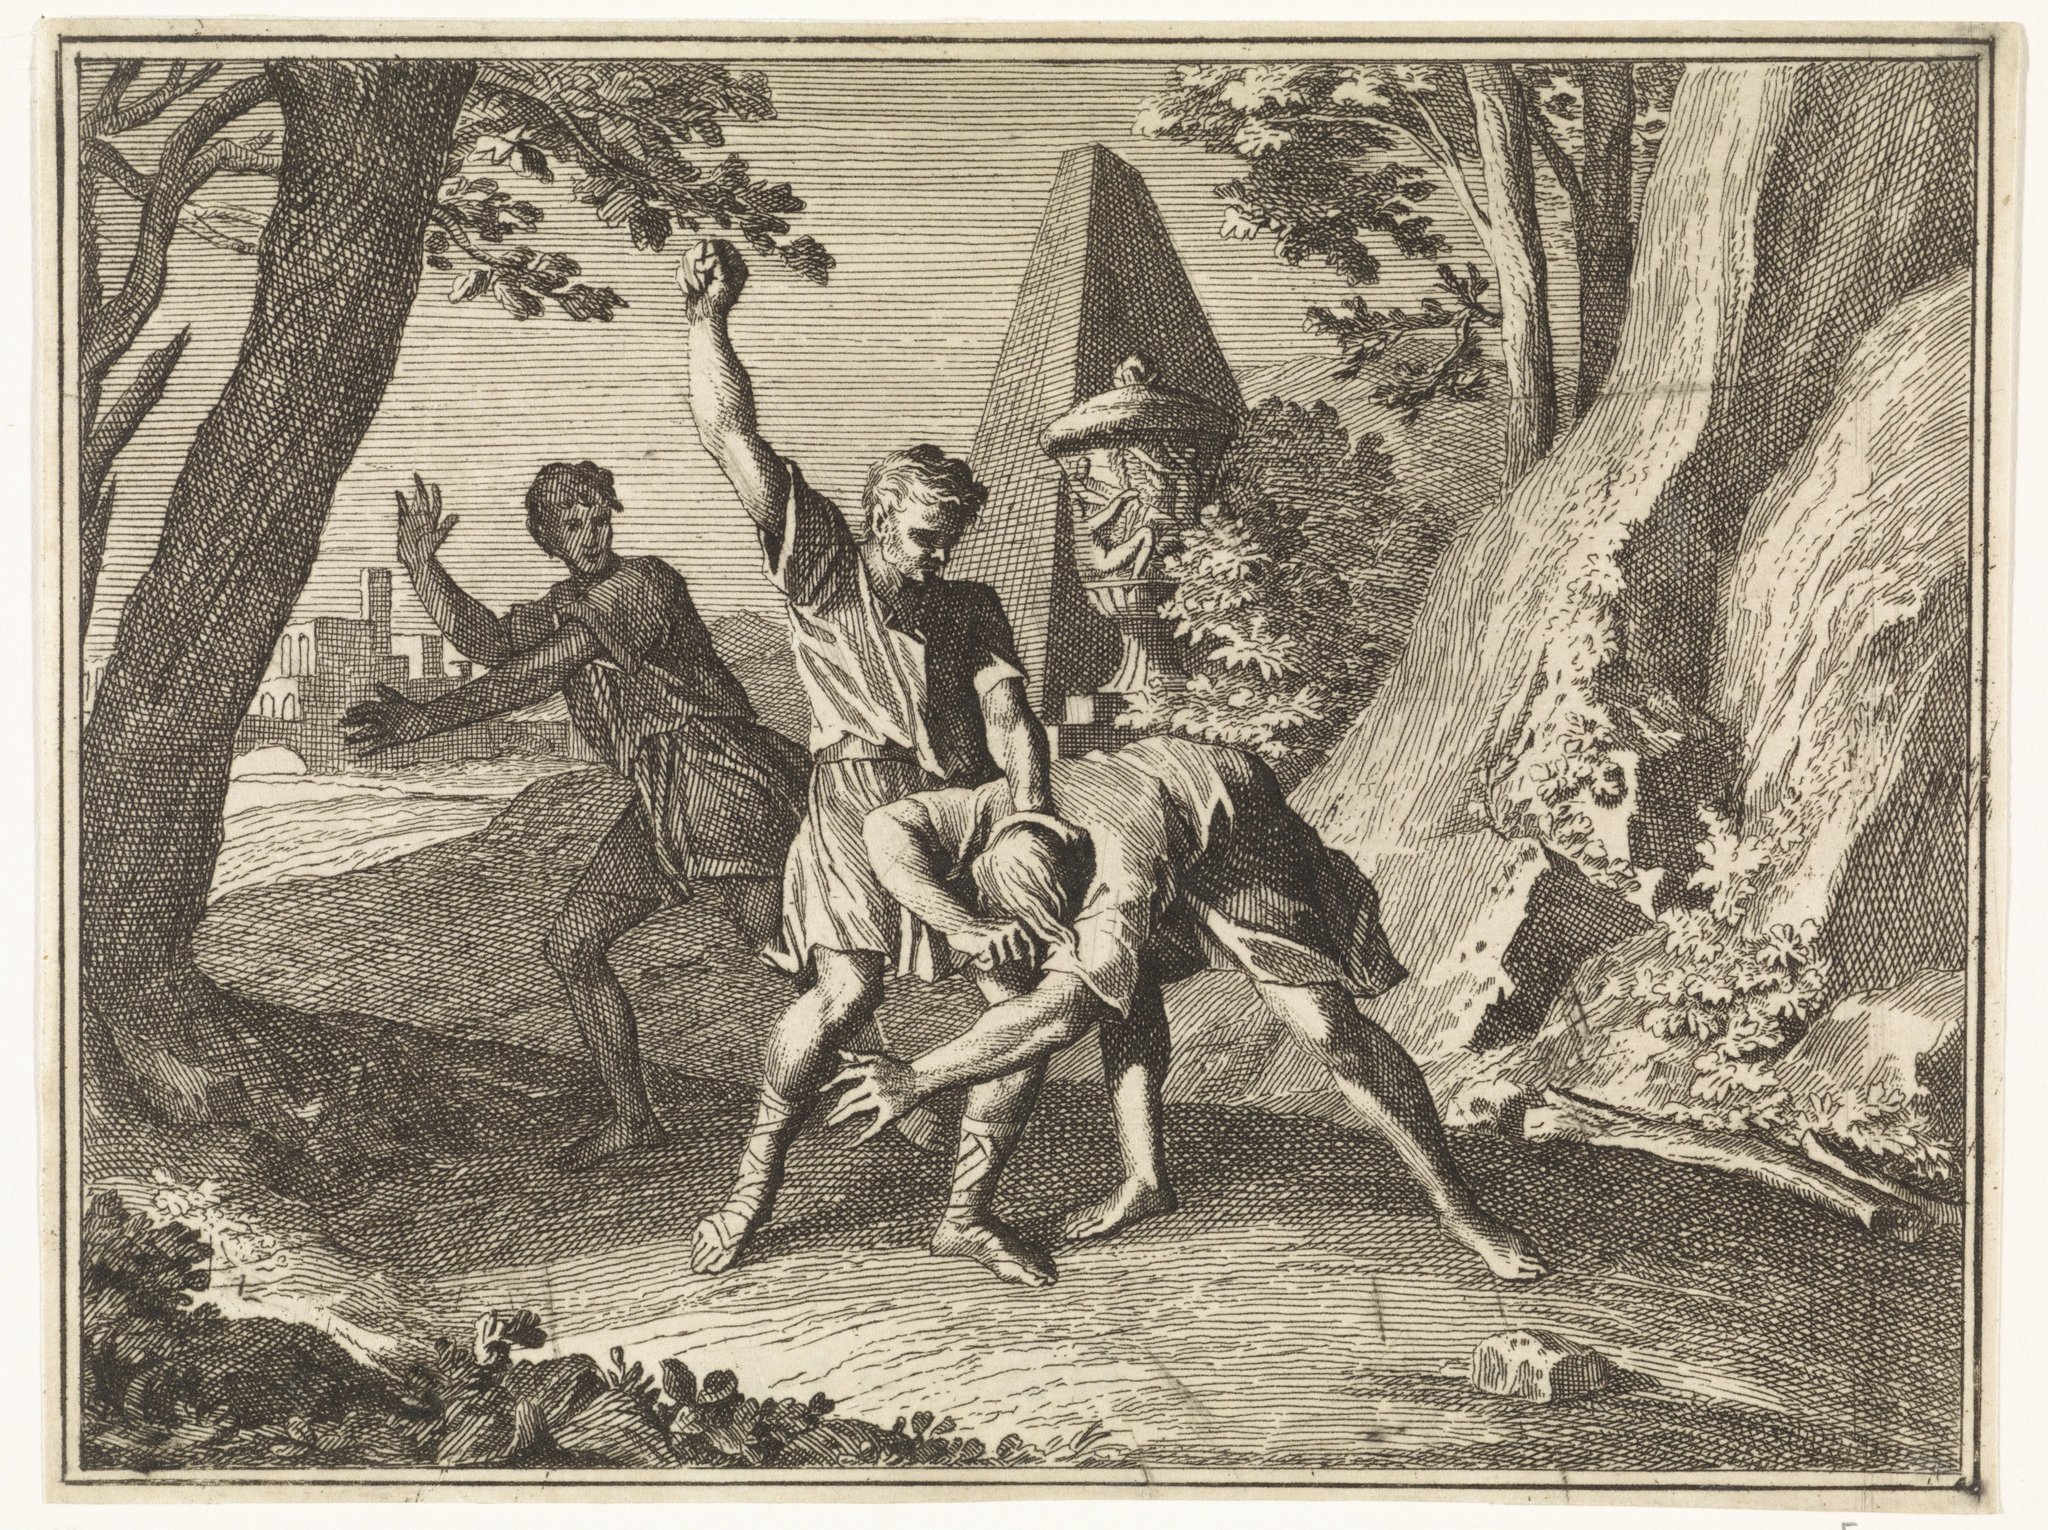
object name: print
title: Mozes verslaat de Egyptenaar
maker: caspar luyken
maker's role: draughtsman, print maker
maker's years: 1672-1708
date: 1712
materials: paper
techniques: etching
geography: amsterdam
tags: moses kills the egyptian taskmaster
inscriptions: collector's mark: Lugt 2228, number: ‘45’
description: Illustratie uit: Luyken, Jan. De schriftuurlyke geschiedenissen en gelykenissen van het Oude en Nieuwe Verbond, 2 delen. Amsterdam: Wed. Pieter Arentsz II en Cornelis van der Sys, 1712, dl. I.